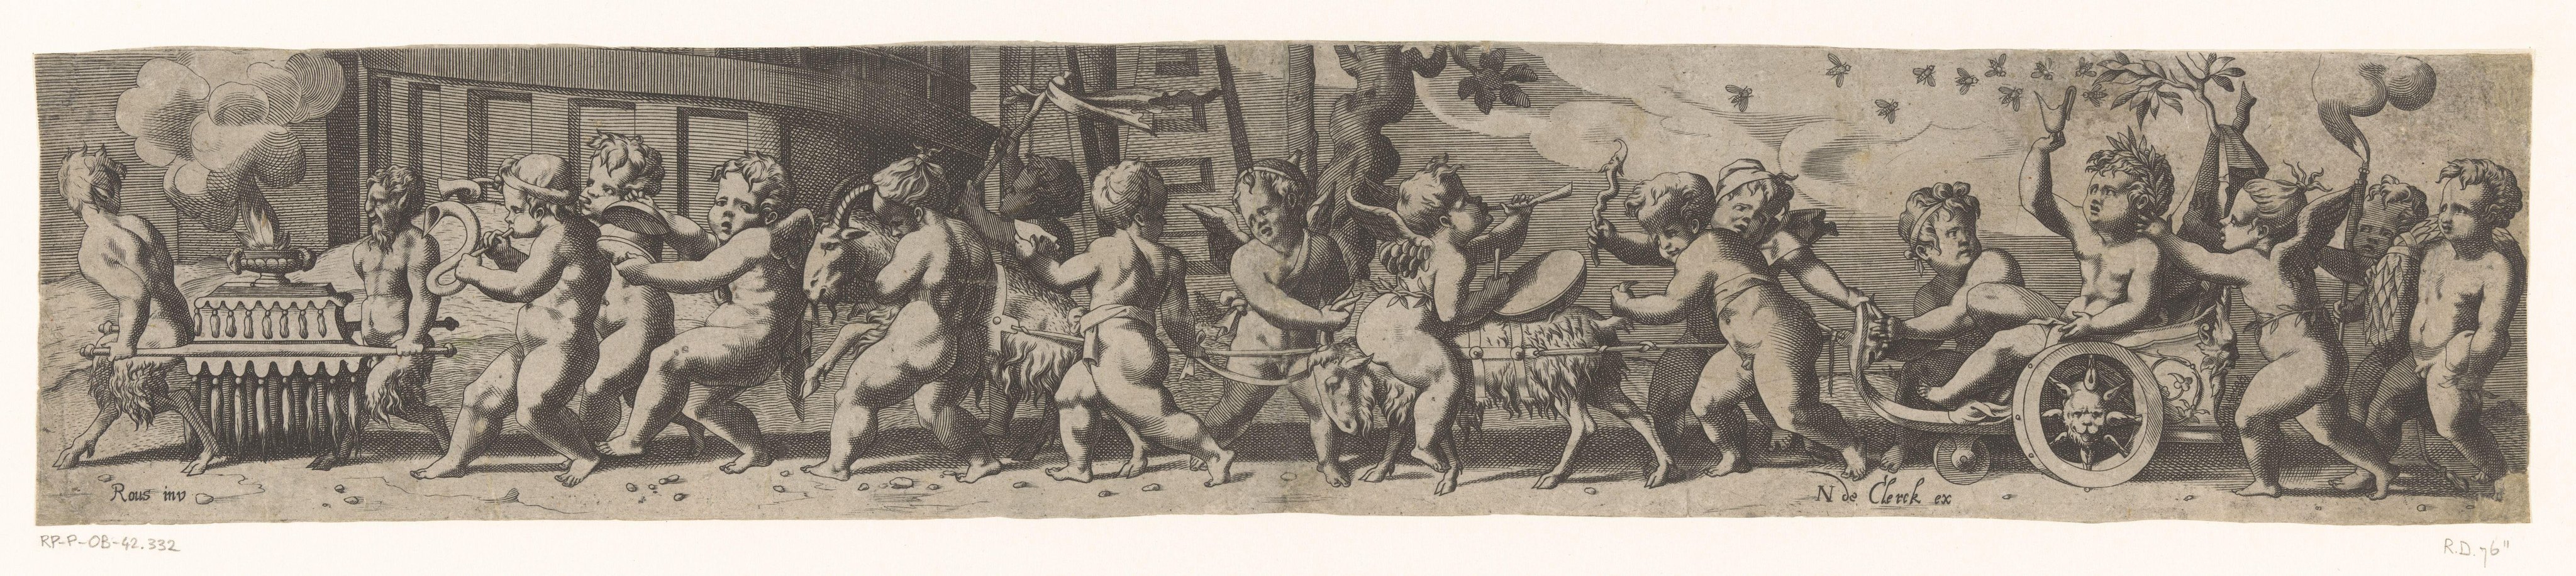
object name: print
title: Bacchanaal van kinderen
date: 1535-1598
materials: paper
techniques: engraving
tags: children's bacchanal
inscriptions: collector's mark: Lugt 240